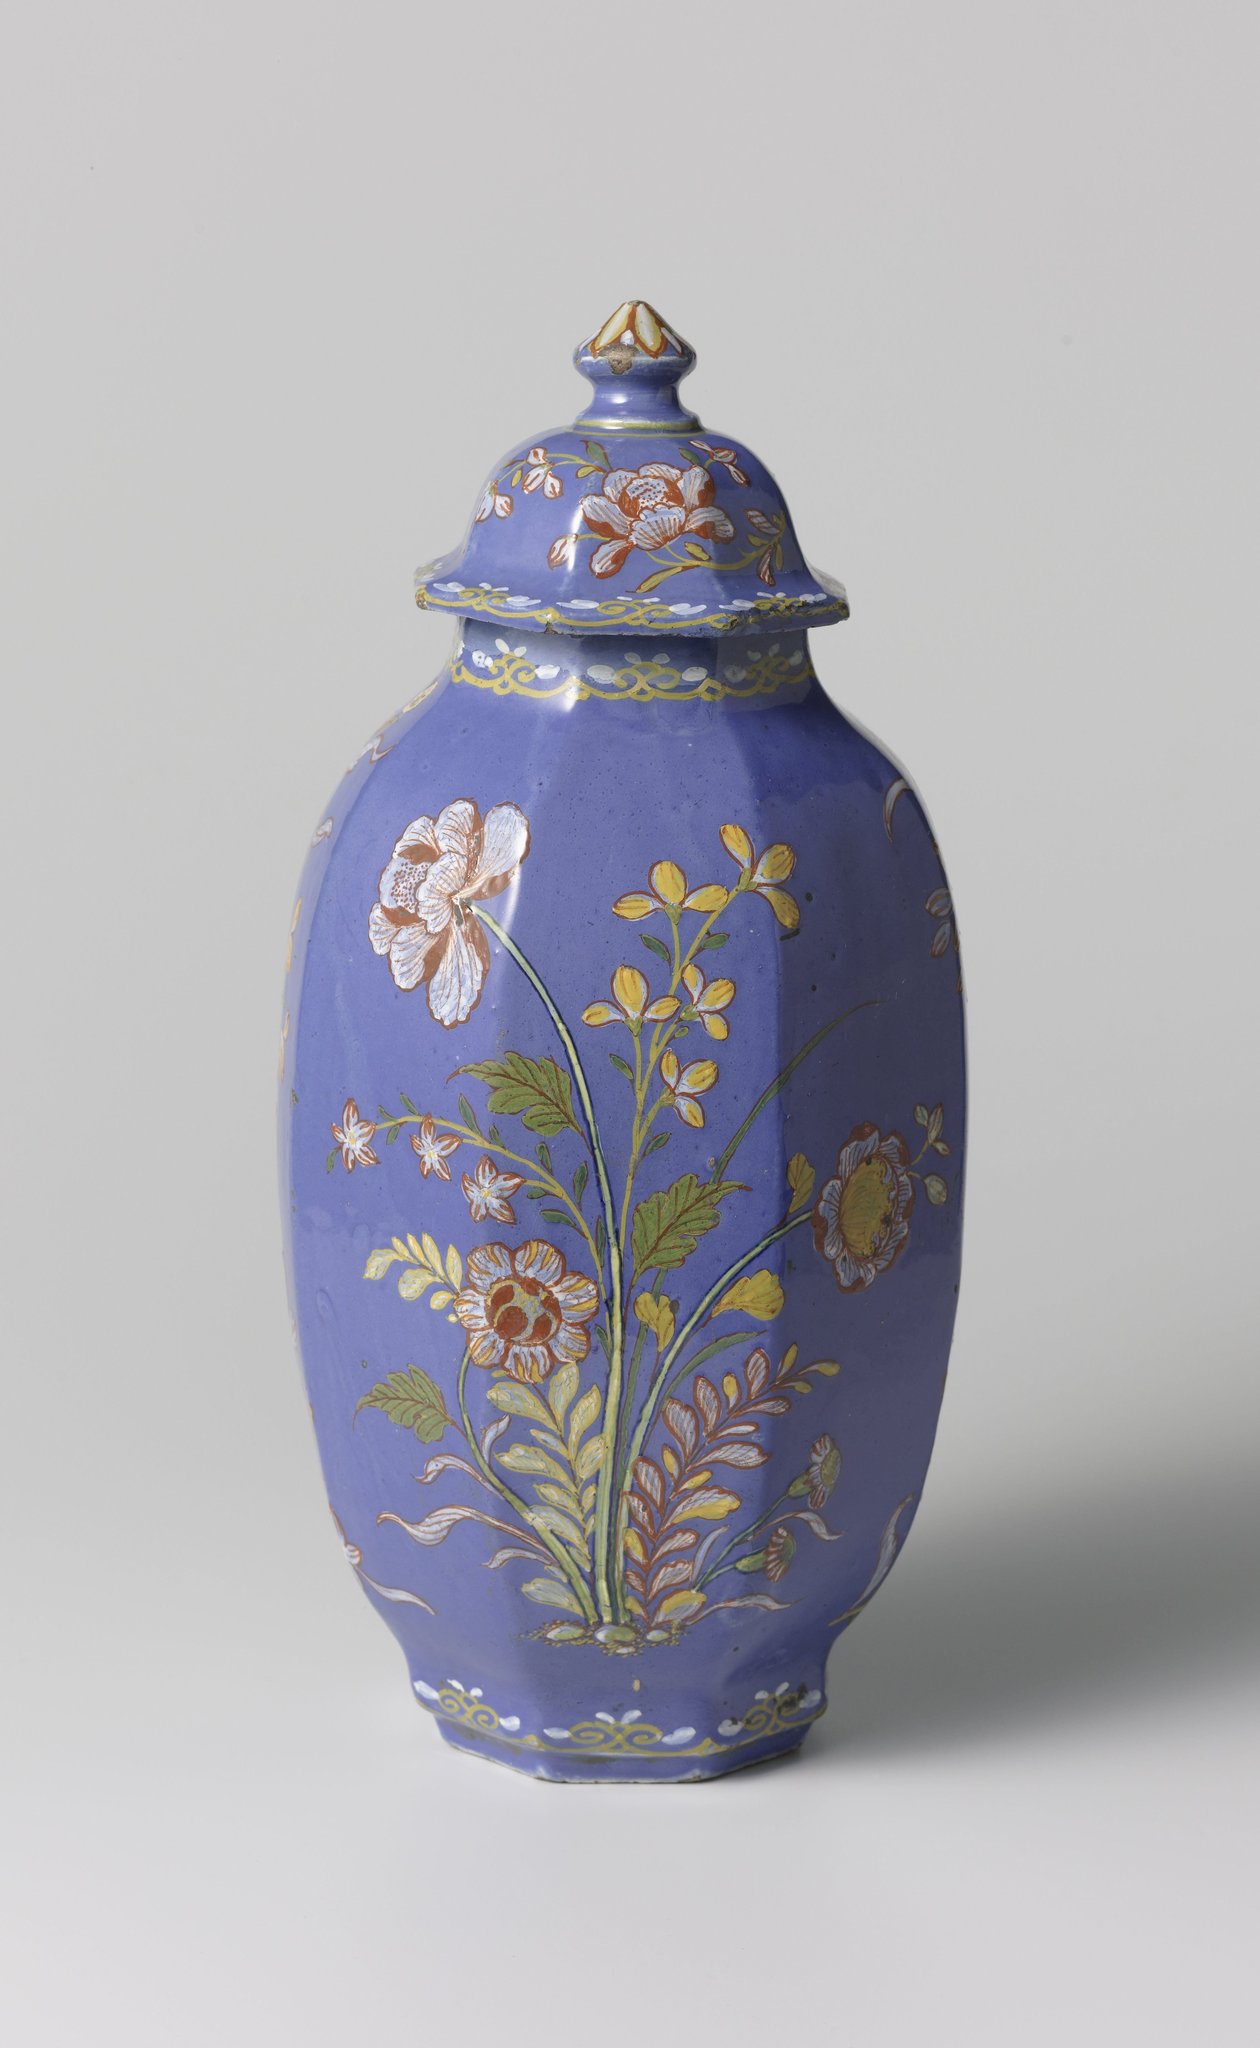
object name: covered jar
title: Pot met deksel van veelkleurig beschilderde faïence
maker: Anonymous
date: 1700-1735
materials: faience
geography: delft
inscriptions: label: ‘363’, mark: ‘D/ 12/ 8’, collector's mark: ‘collection JF Loudon’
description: Pot met deksel van faïence. Veelkleurig beschilderd met bloemen op een blauw fond.